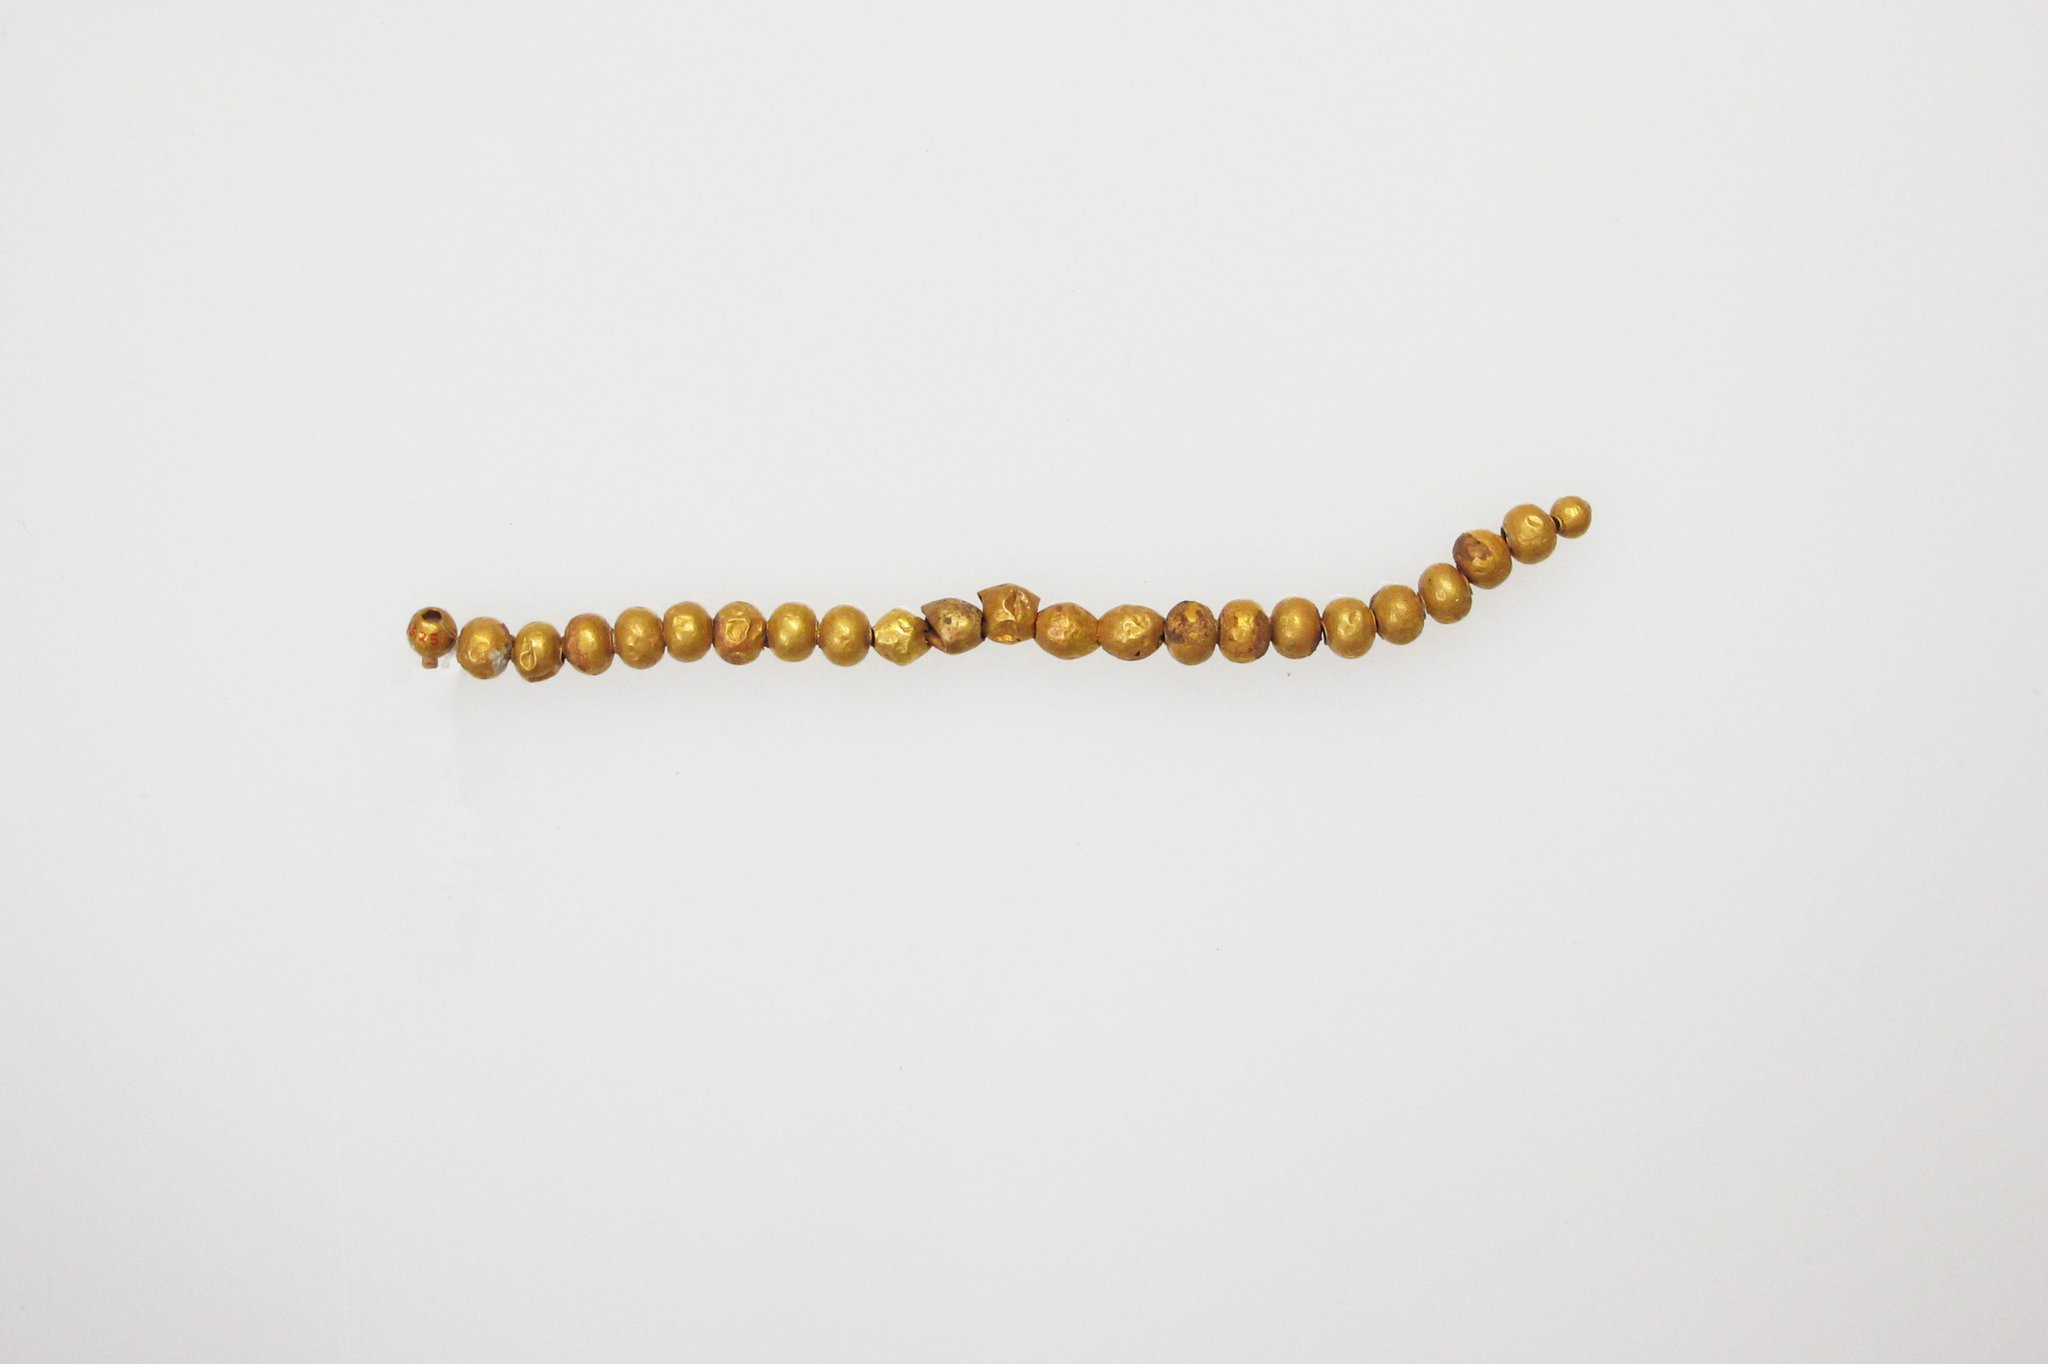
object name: bead, 23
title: Beads, 23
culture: etruscan or greek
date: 600-401 BCE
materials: gold foil